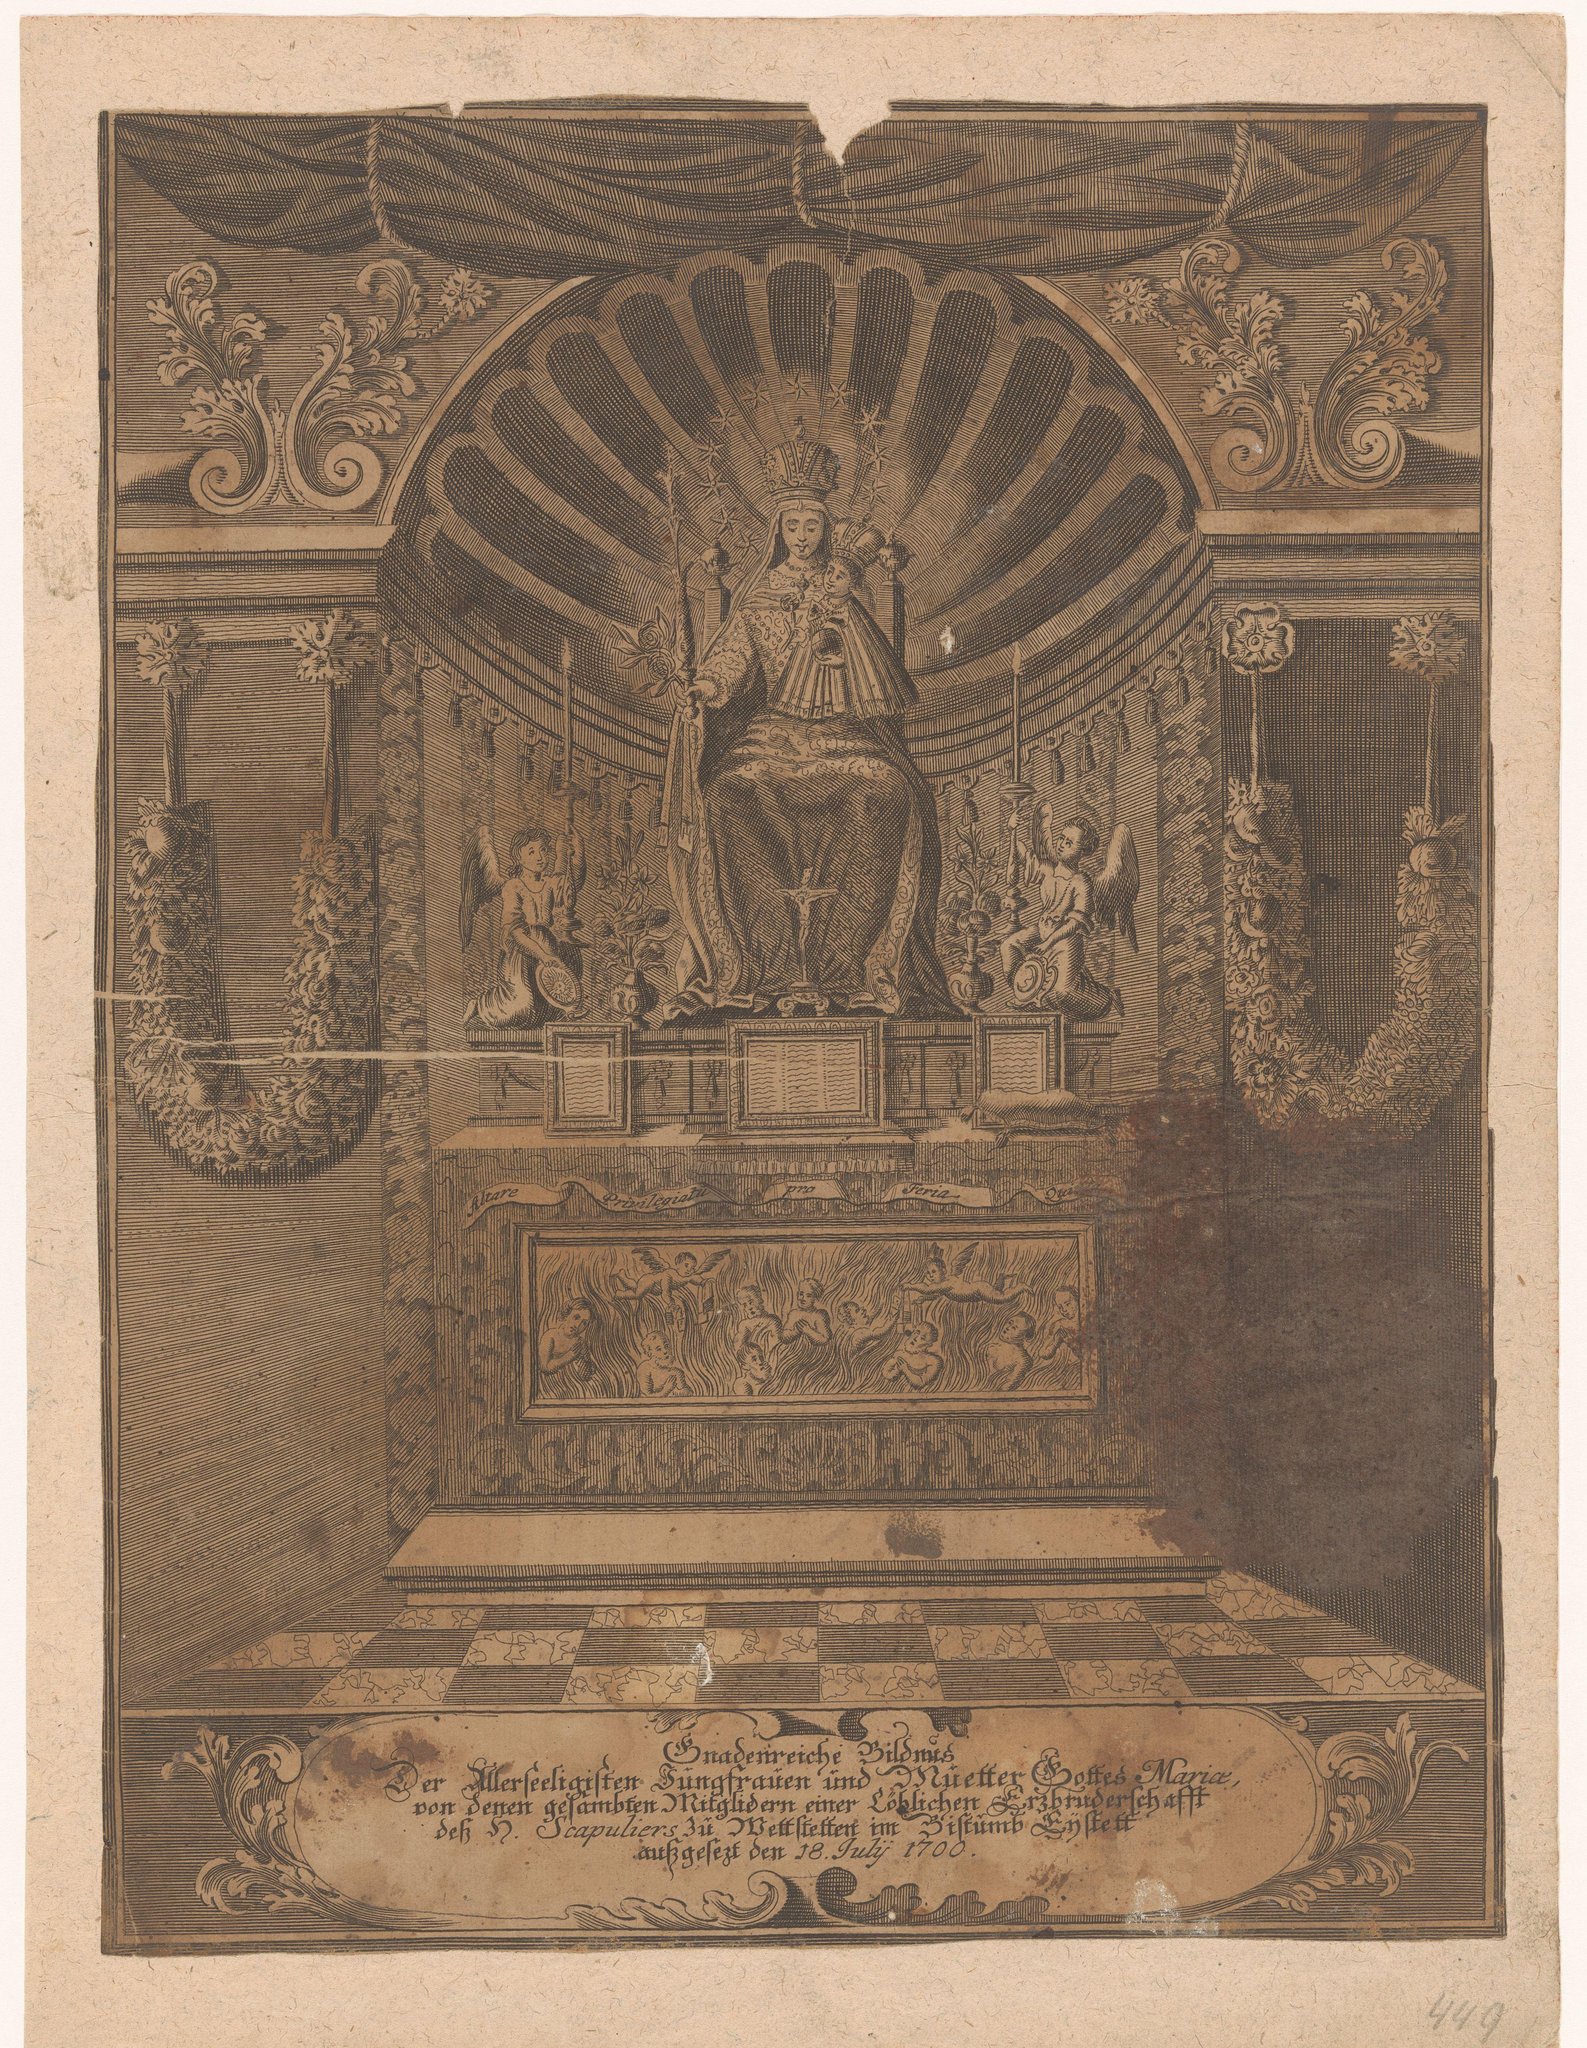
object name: print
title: Altaar van het bisdom 'Eijstett'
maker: Anonymous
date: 1700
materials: paper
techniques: engraving, etching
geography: germany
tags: altar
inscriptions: collector's mark: Lugt 2228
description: Mogelijk betreft dit een altaar van de kathedraal van Eichstätt.